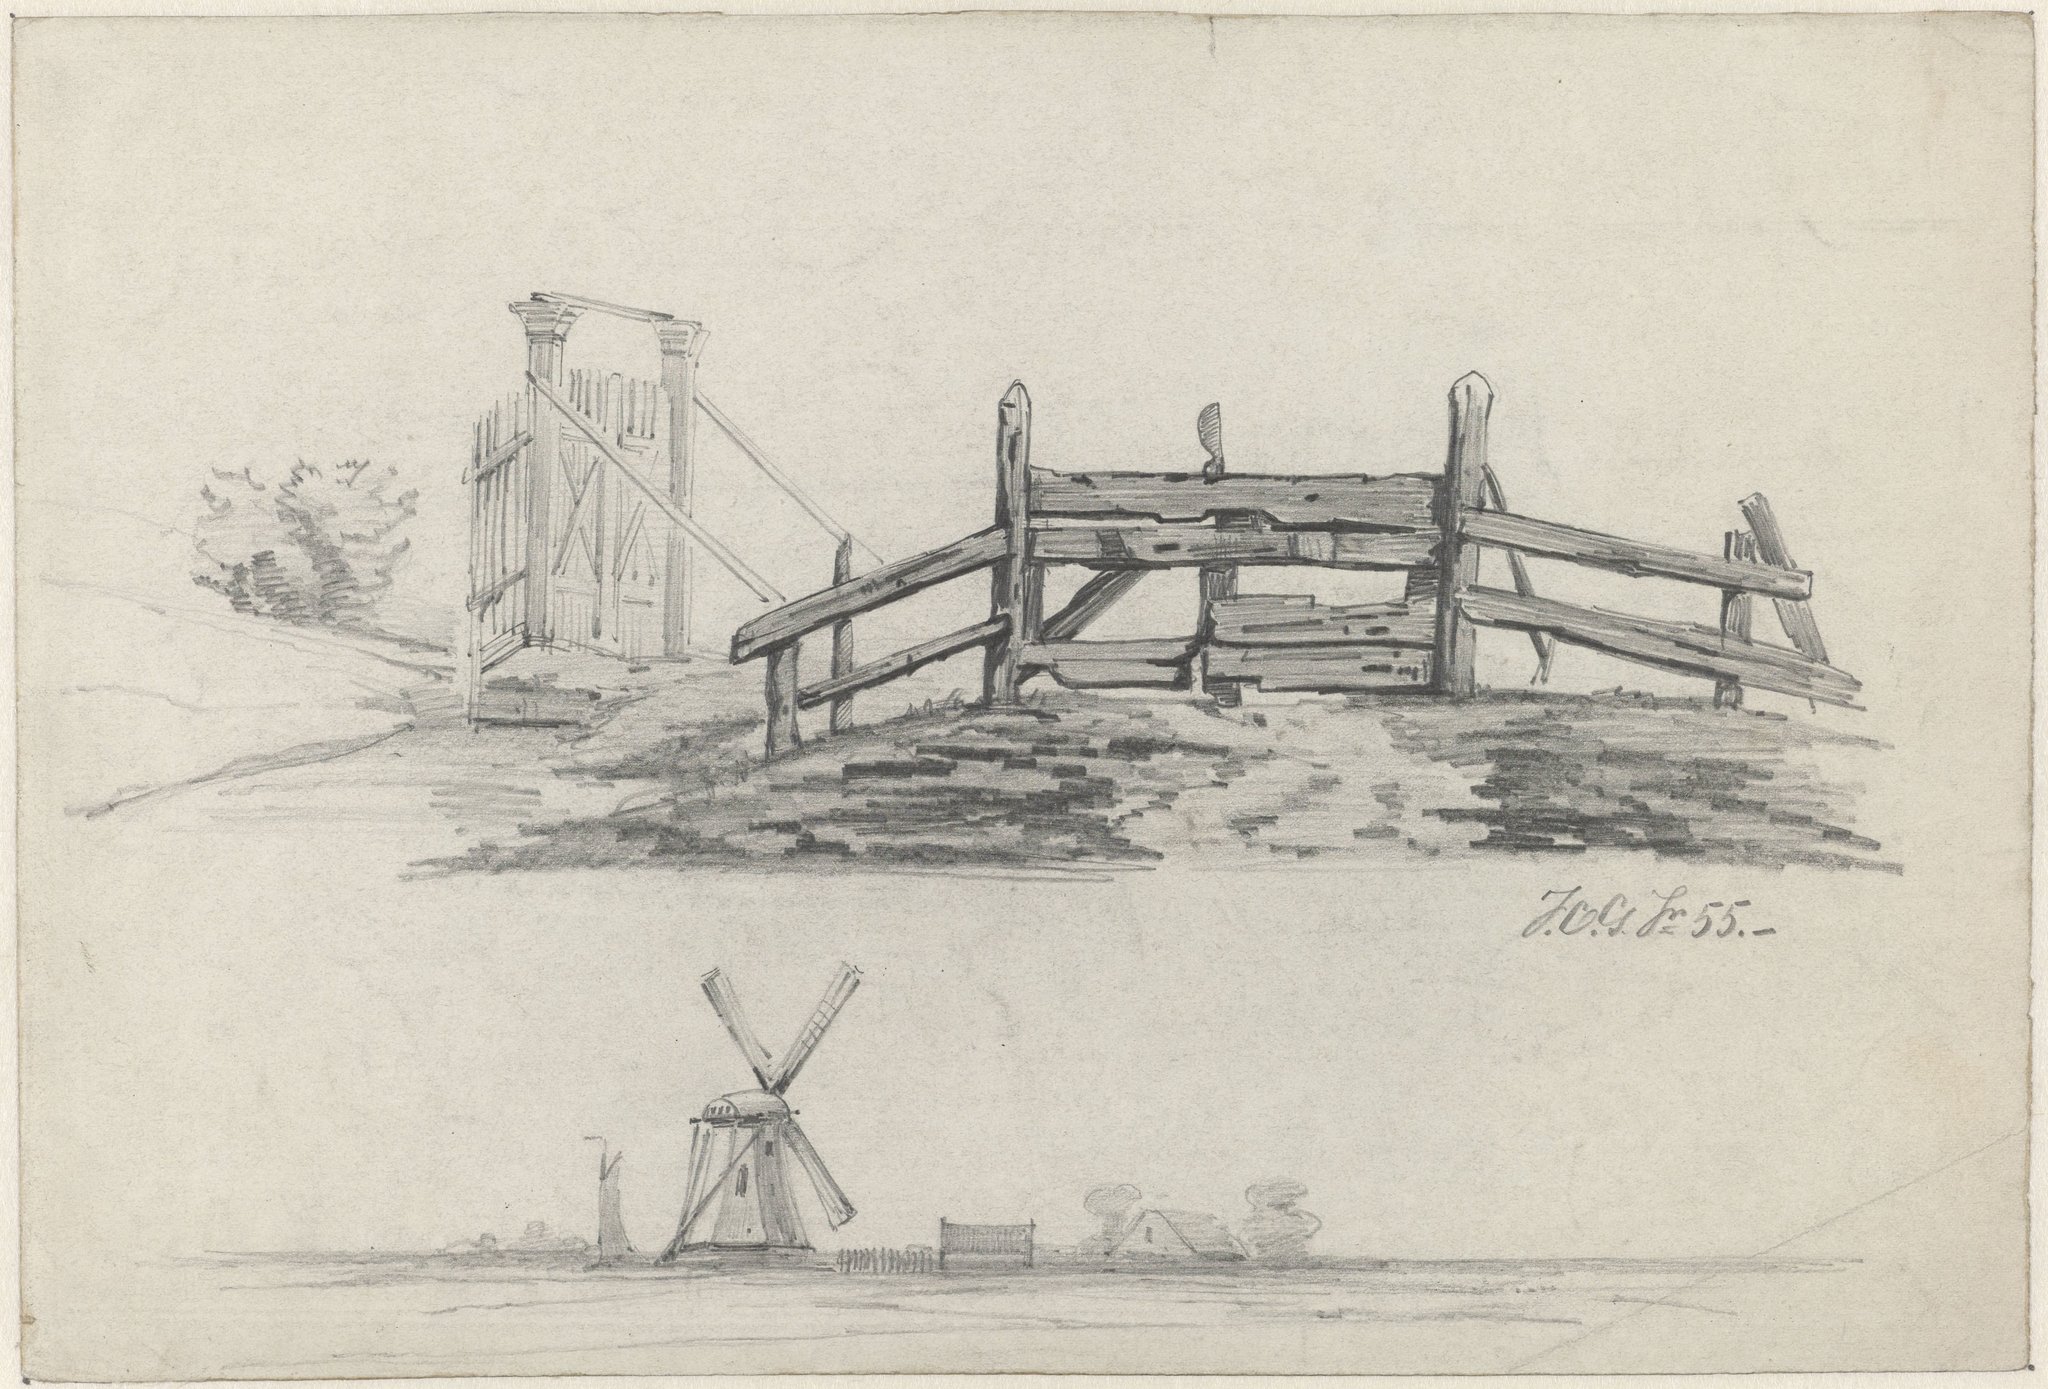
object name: drawing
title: Studies van een hek, een poort en een landschap met windmolen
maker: johan conrad greive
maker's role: draughtsman, painter, print maker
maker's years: 1837-1891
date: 1855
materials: paper, pencil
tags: windmill in landscape